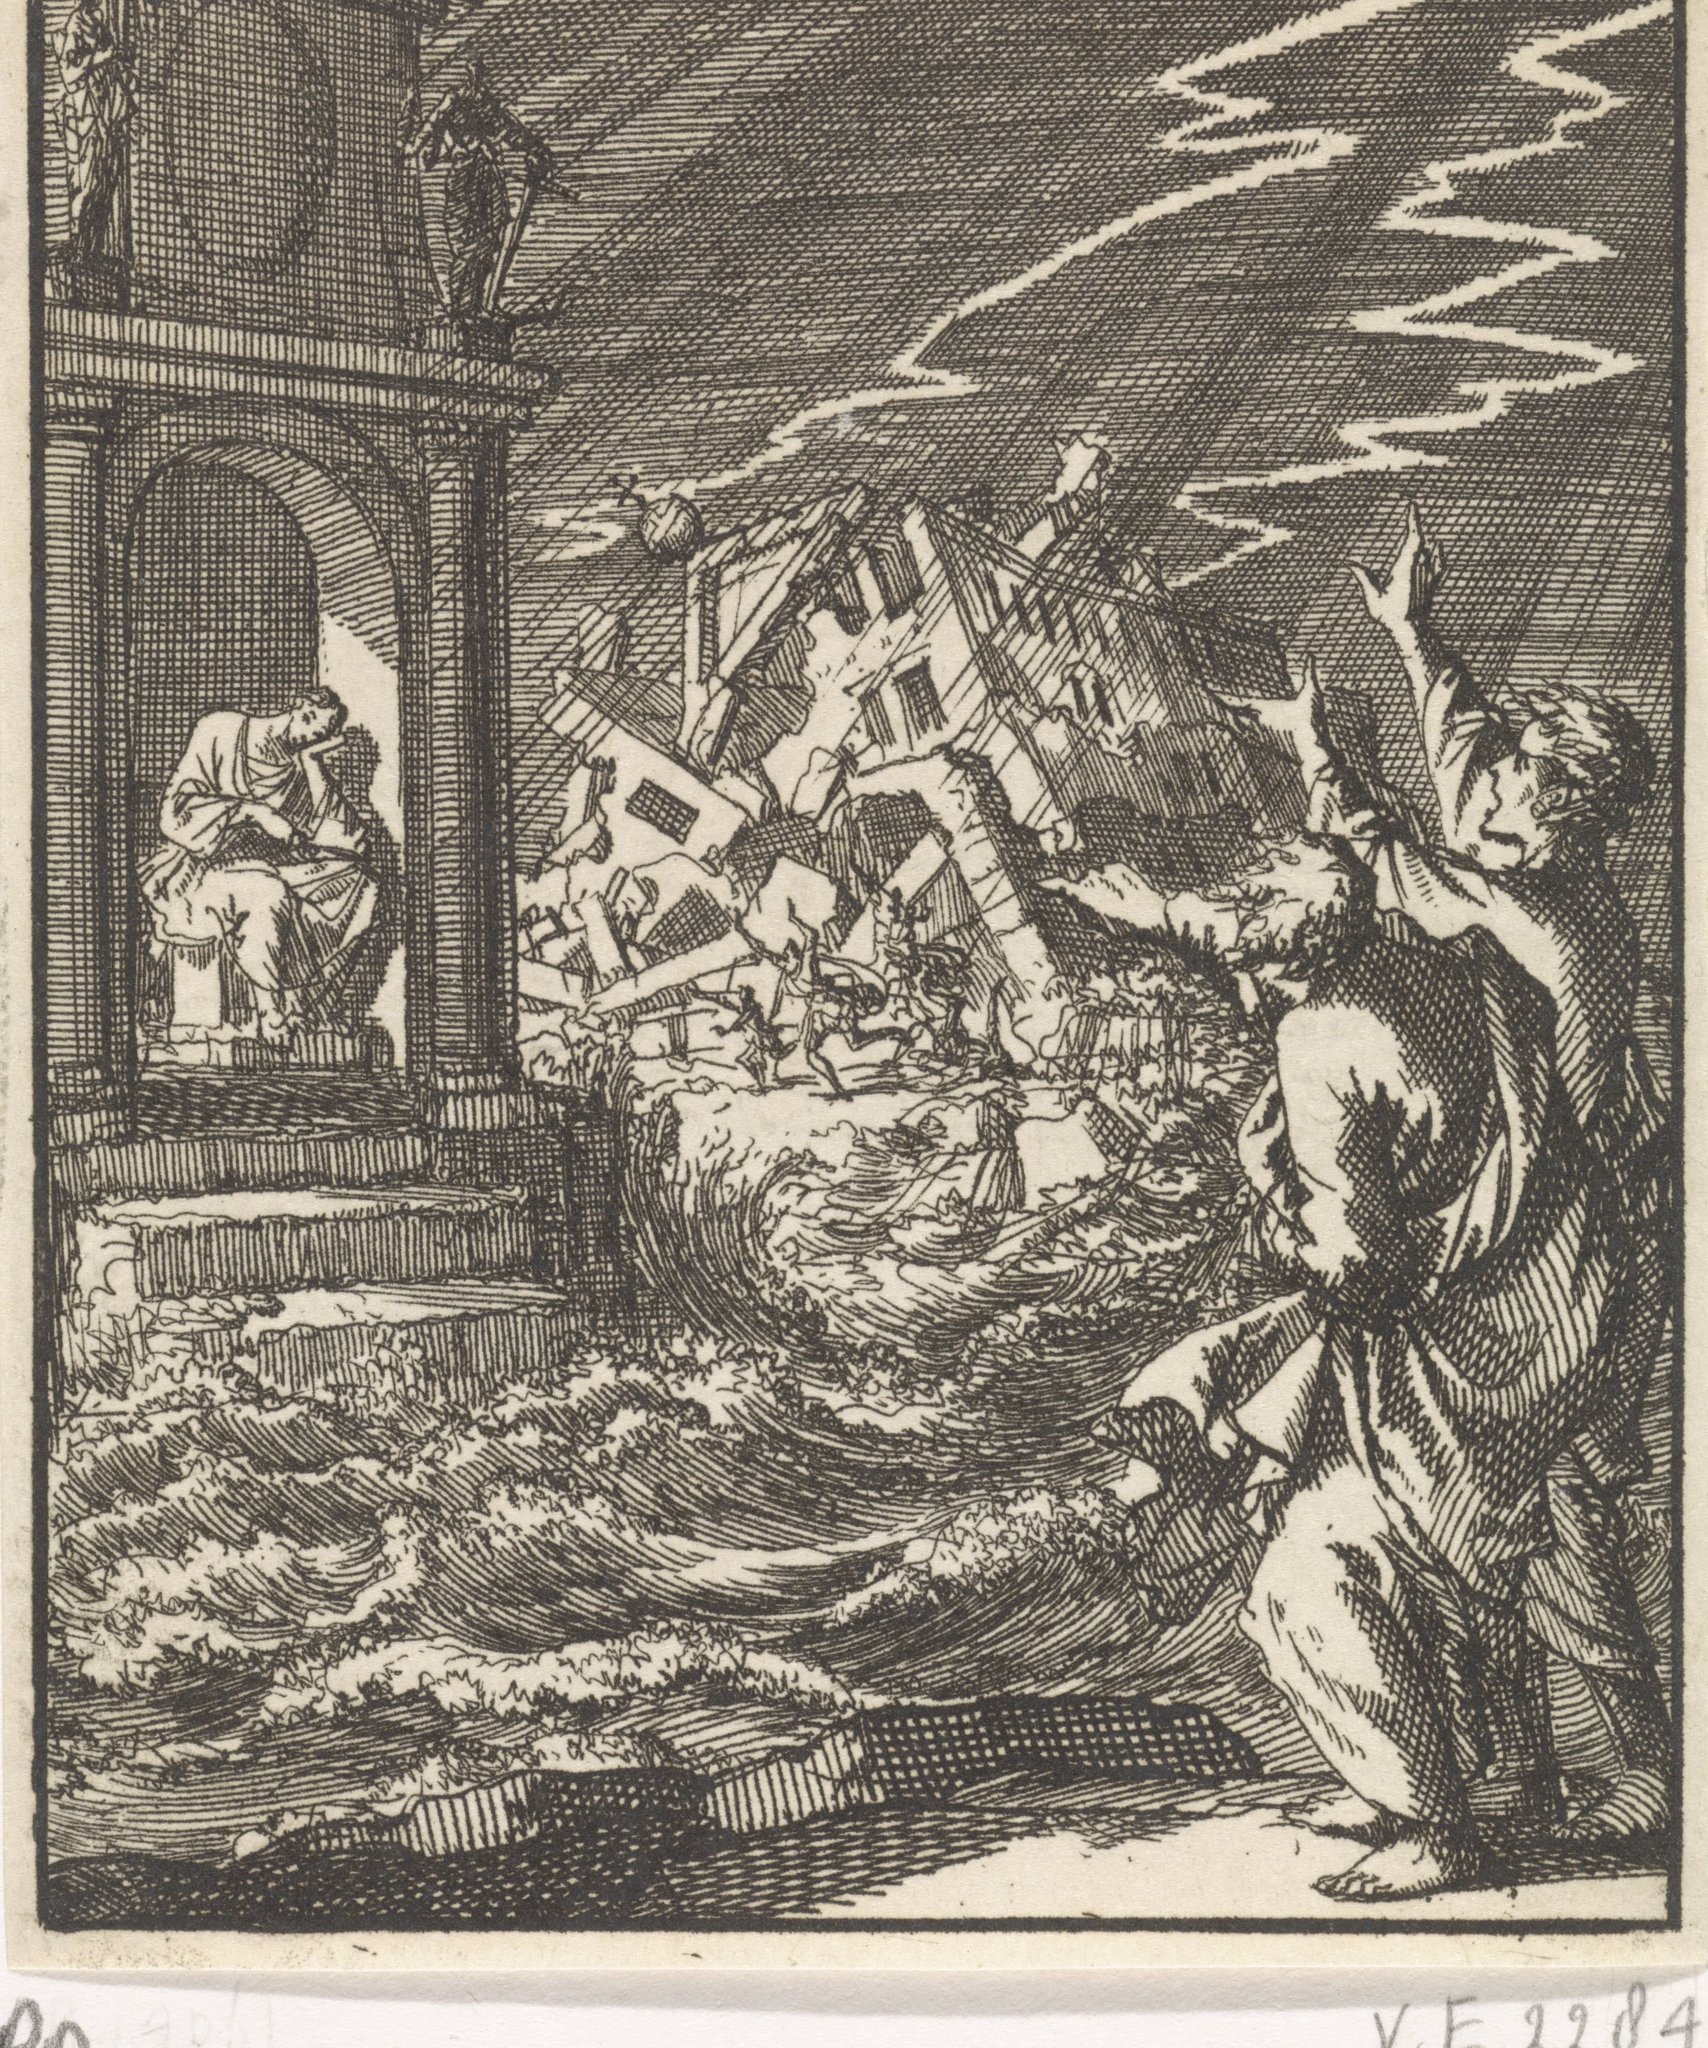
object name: book illustration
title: De Ware Gelovige slapend tijdens een storm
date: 1699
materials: paper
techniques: etching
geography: amsterdam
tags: sleeping; unconsciousness, the believer, storm on land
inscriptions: collector's mark: Lugt 2228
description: Tijdens een storm slaapt de personificatie Waar Geloof in een portaal. Rond hem storten gebouwen in elkaar en slaan de golven in op de kade. Twee mannen op de voorgrond trachten hem roepend wakker te maken en hem te wijzen op het gevaar. Waar Geloof slaapt echter door. Zijn geloof bewaart hem voor de storm.